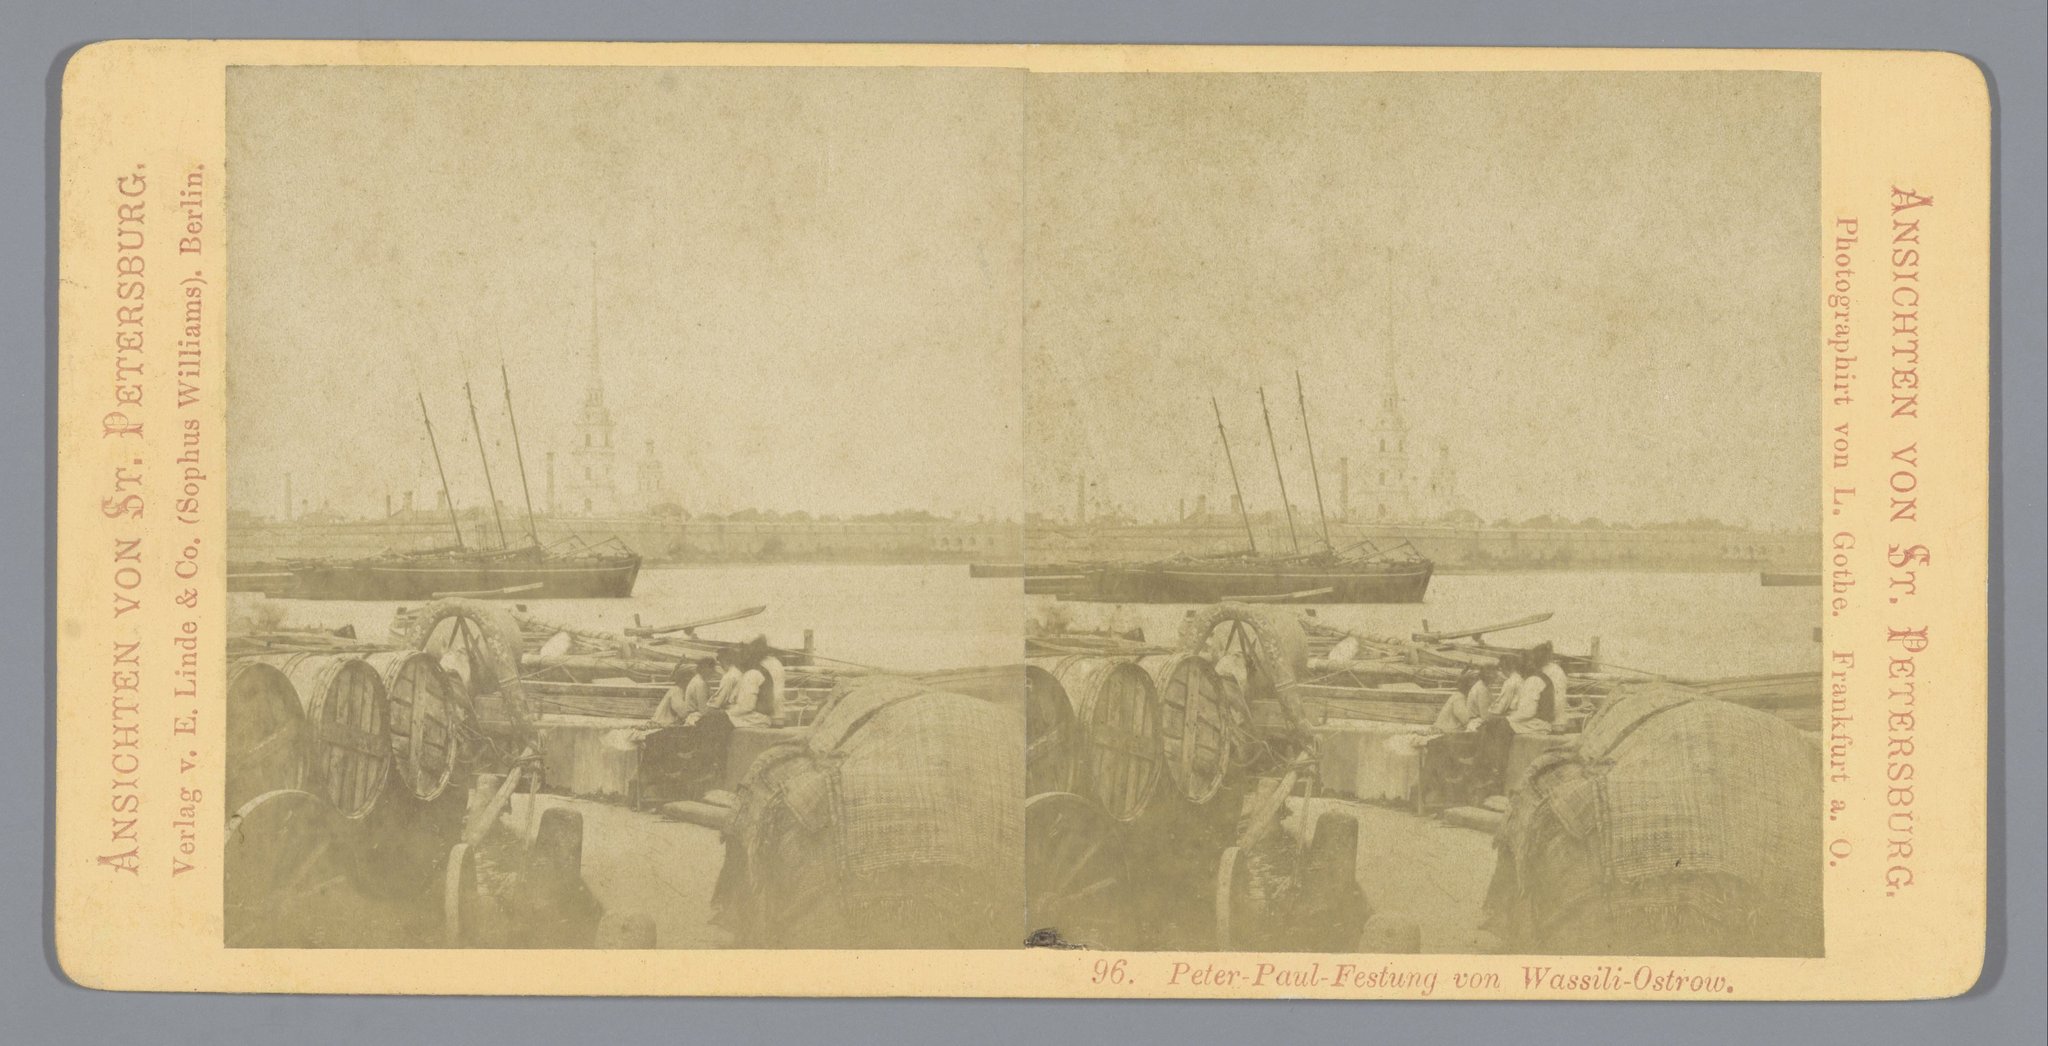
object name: stereograph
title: Peter-Paul-Festung von Wassili-Ostrow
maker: louis gothe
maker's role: fotograaf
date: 1850-1880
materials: cardboard, photographic support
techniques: albumen print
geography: berlin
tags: fortress, quay (+ city(-scape) with figures, staffage)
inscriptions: inscription: ‘Ansichten von St. Petersburg.’, number: ‘96.’